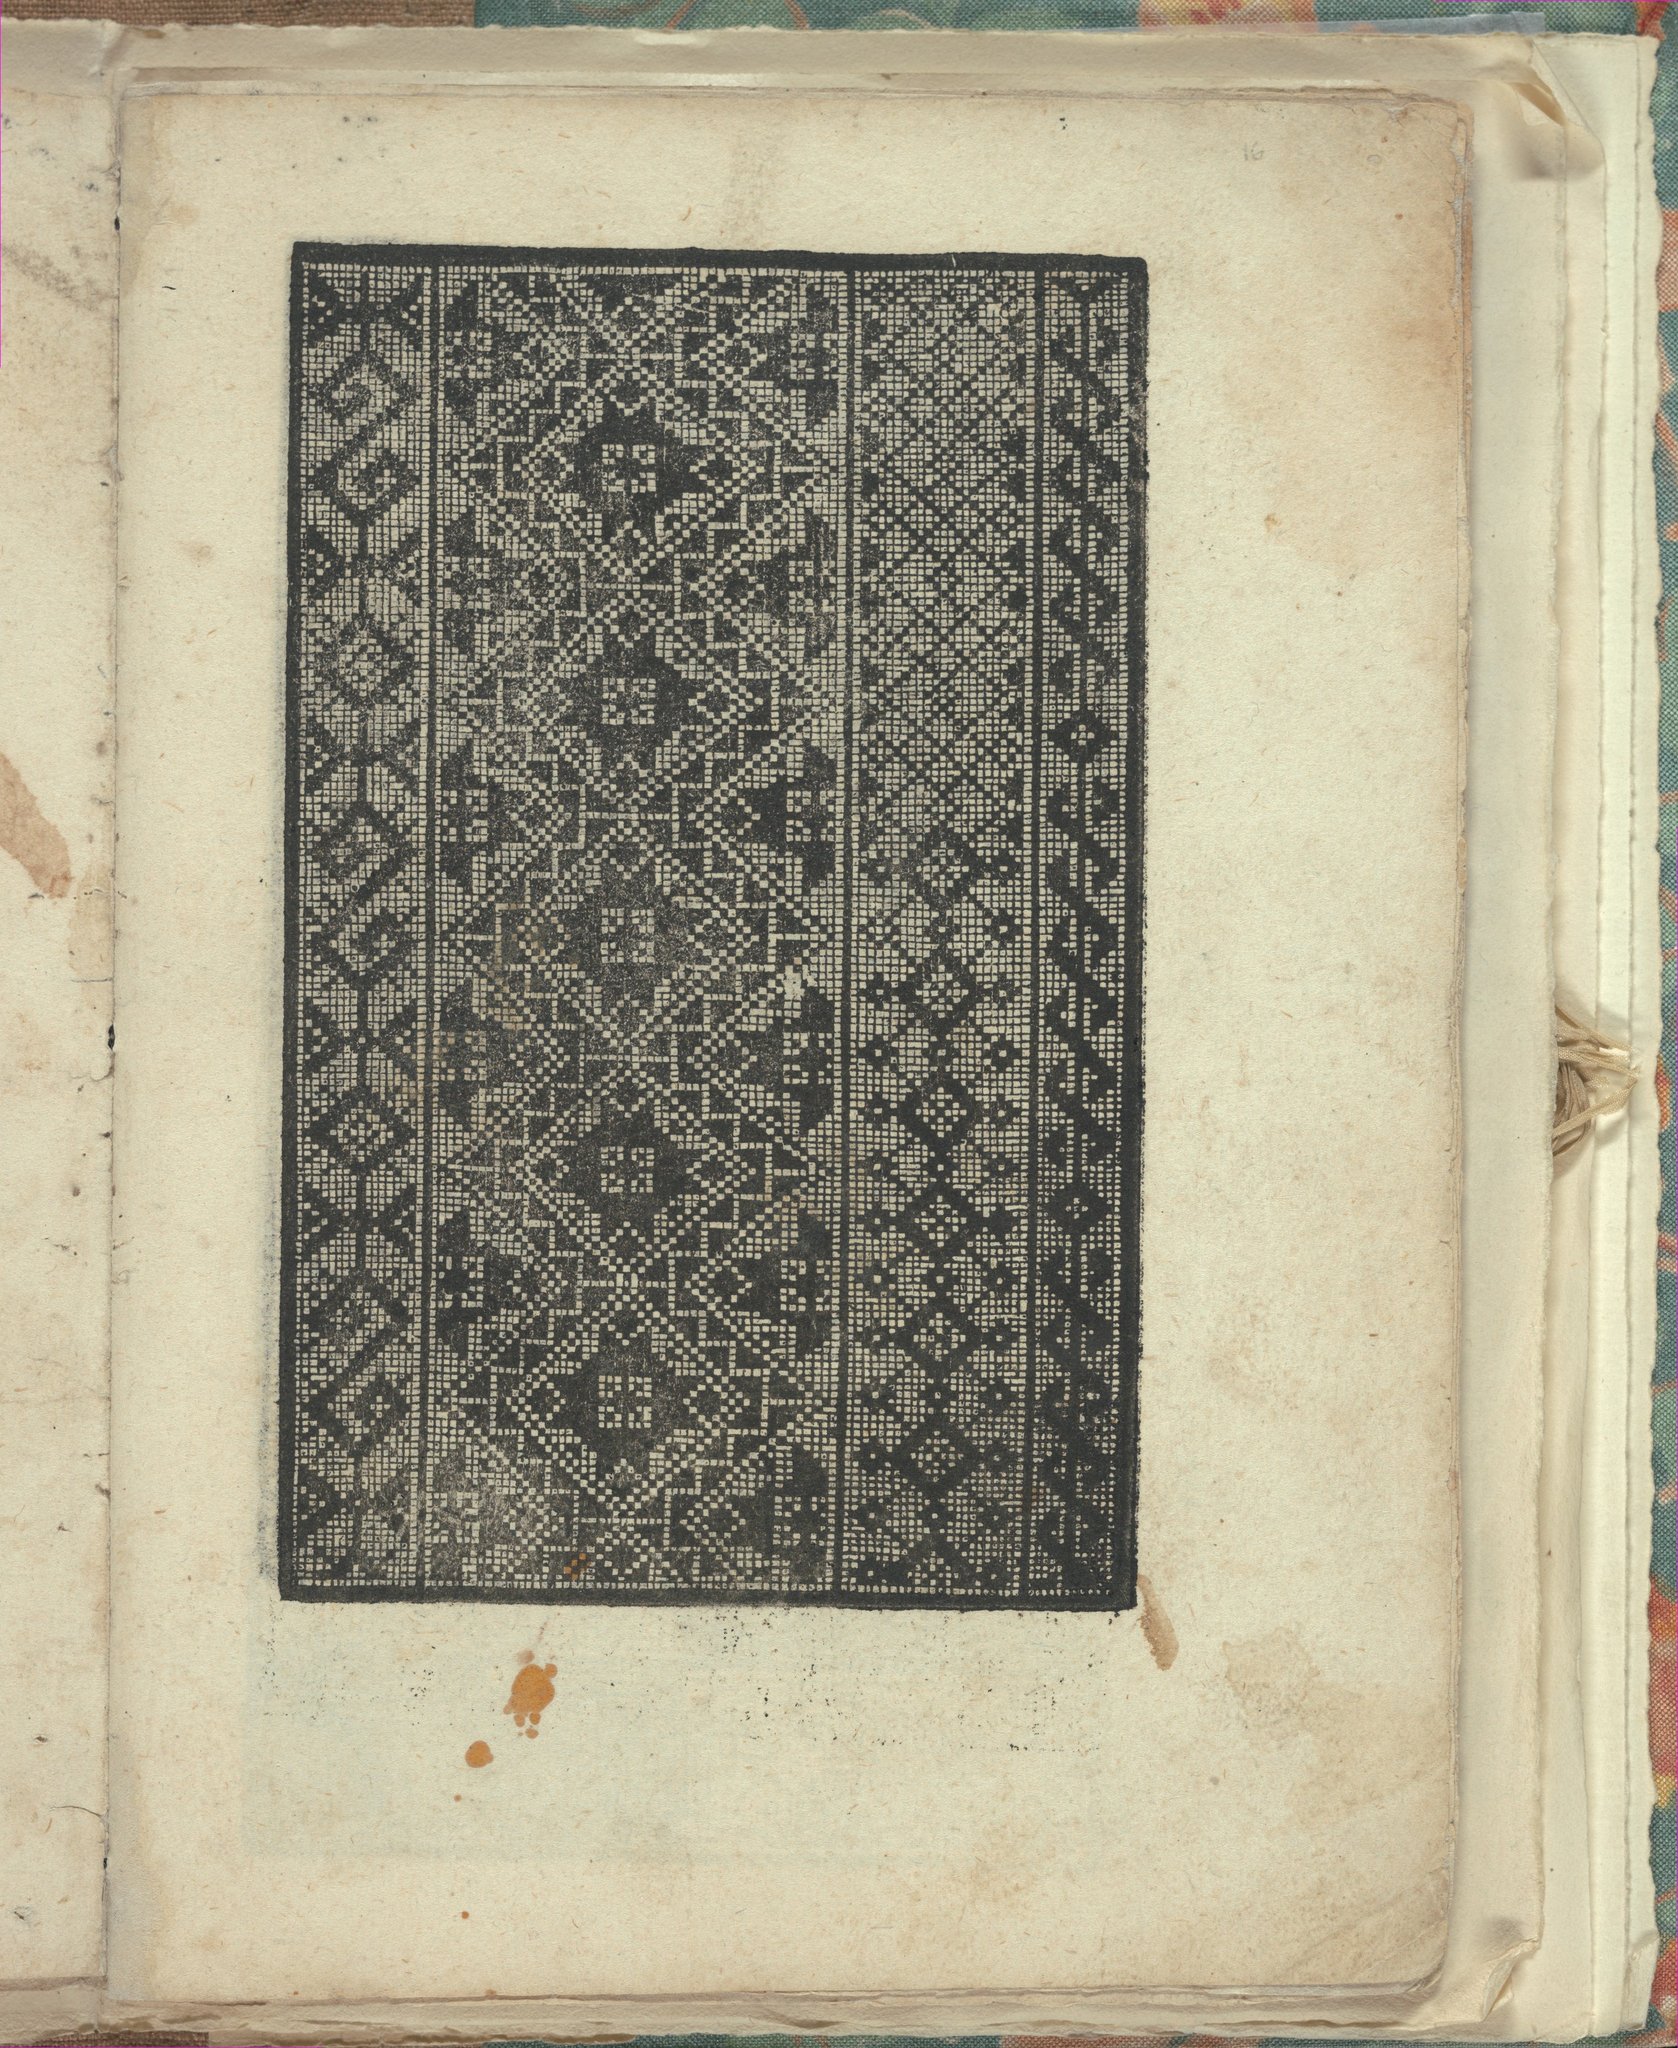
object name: book print ornament architecture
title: Opera Nova Universali intitulata Corona di racammi, page 16 (recto)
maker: giovanni andrea vavassore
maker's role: publisher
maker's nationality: italian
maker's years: 1530-1573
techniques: woodcut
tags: ornament